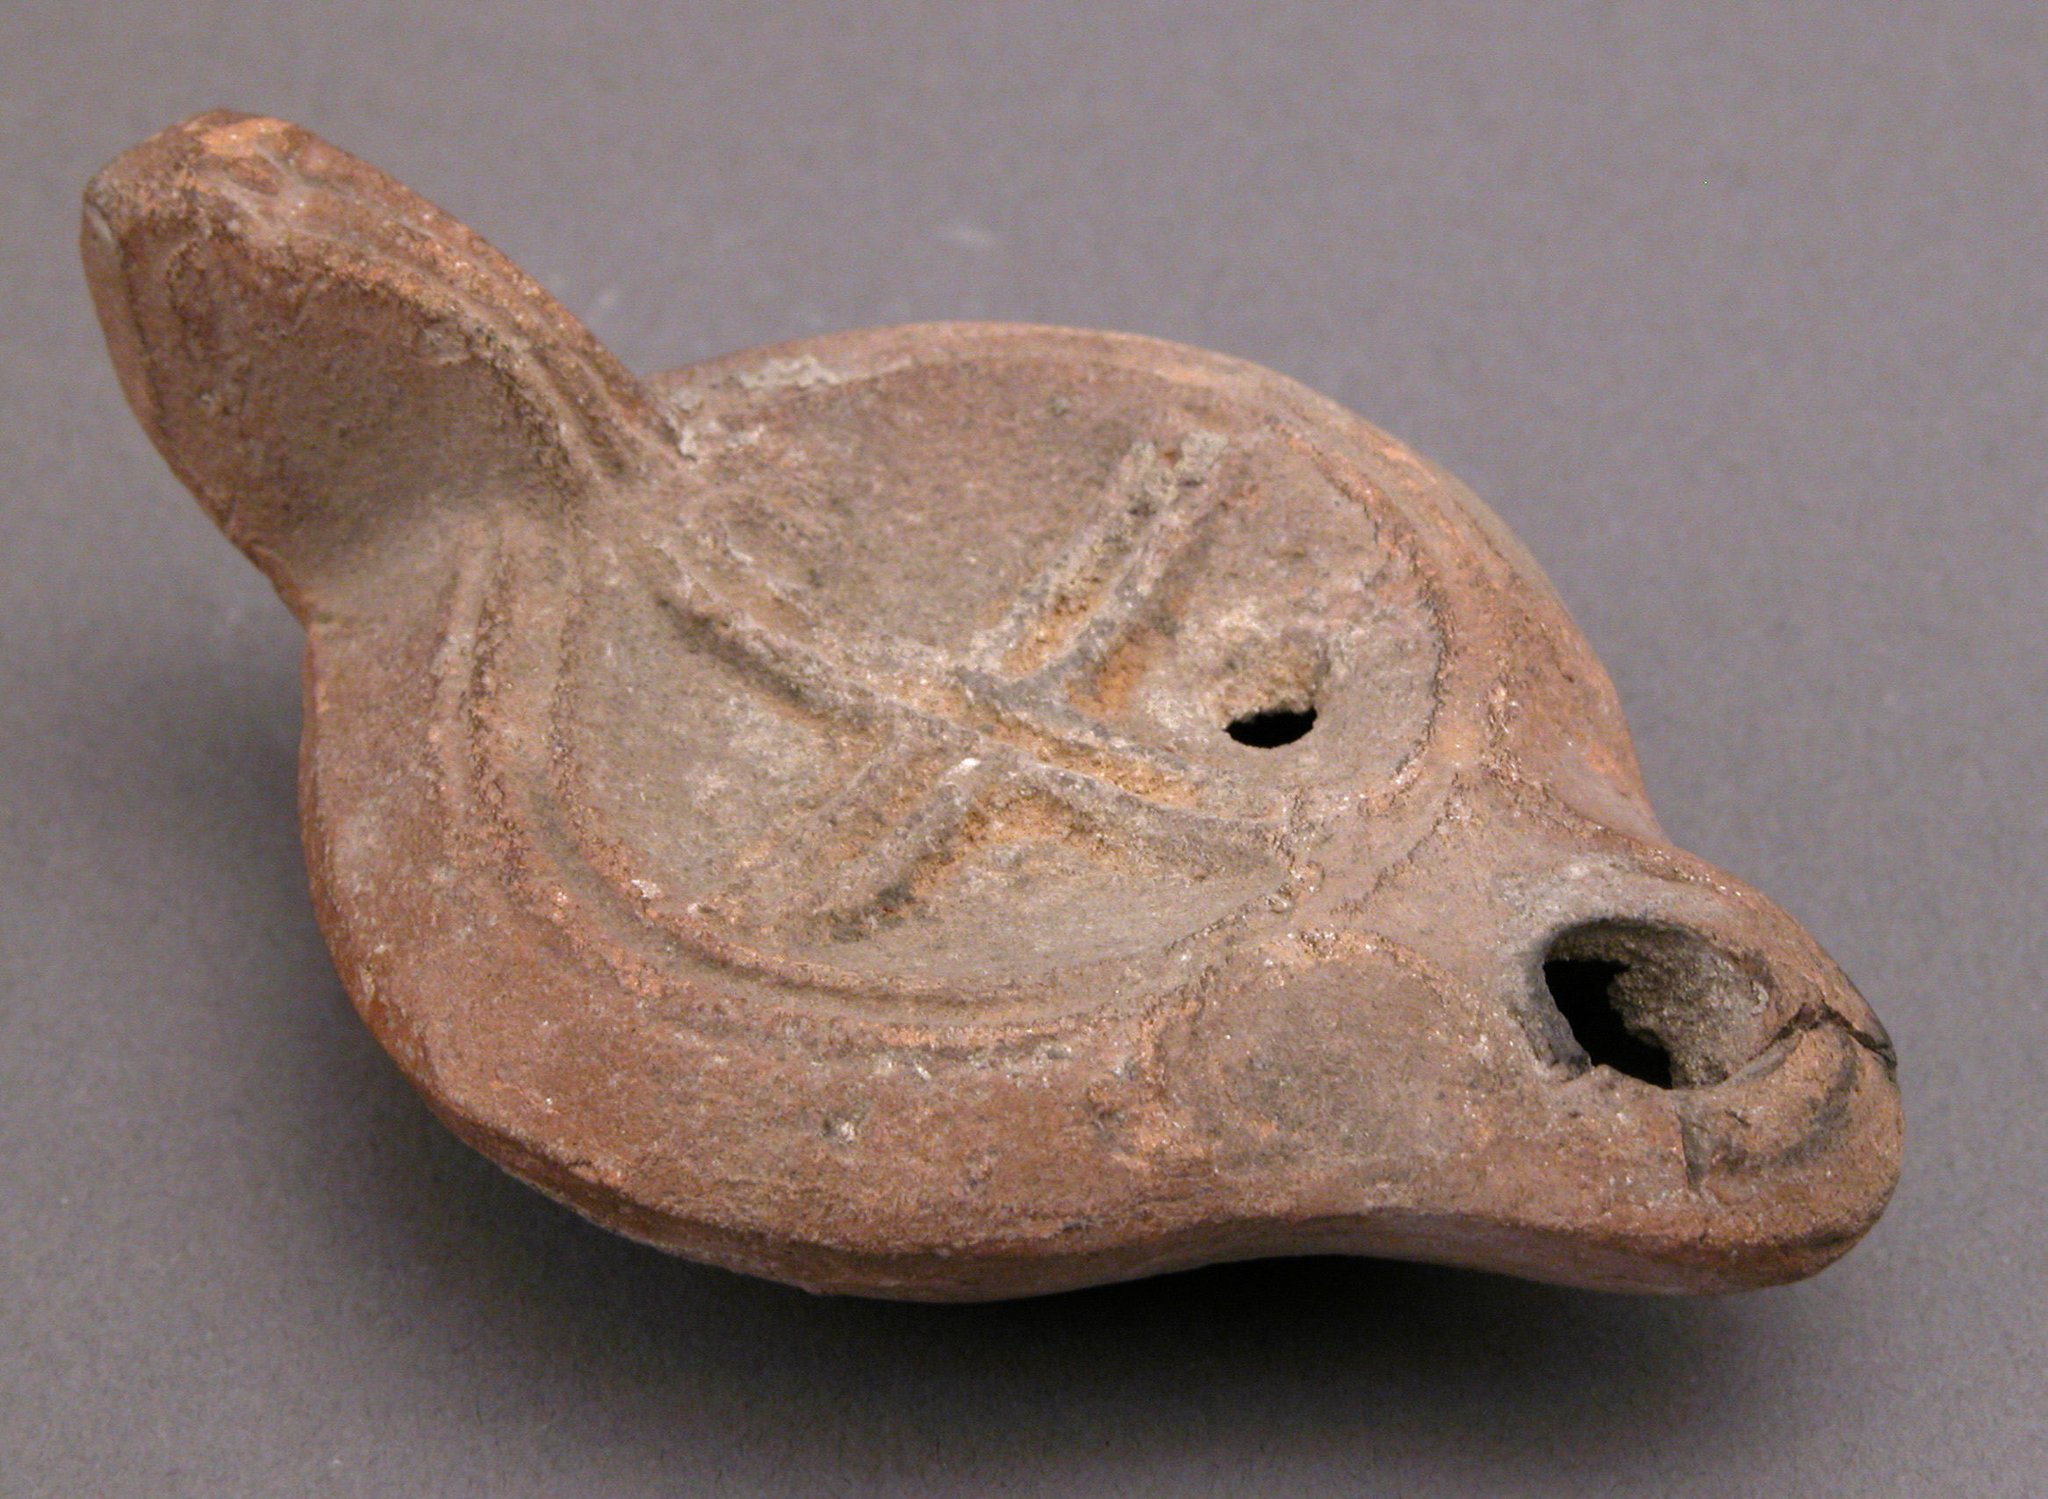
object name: lamp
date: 301-500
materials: earthenware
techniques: molding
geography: egypt